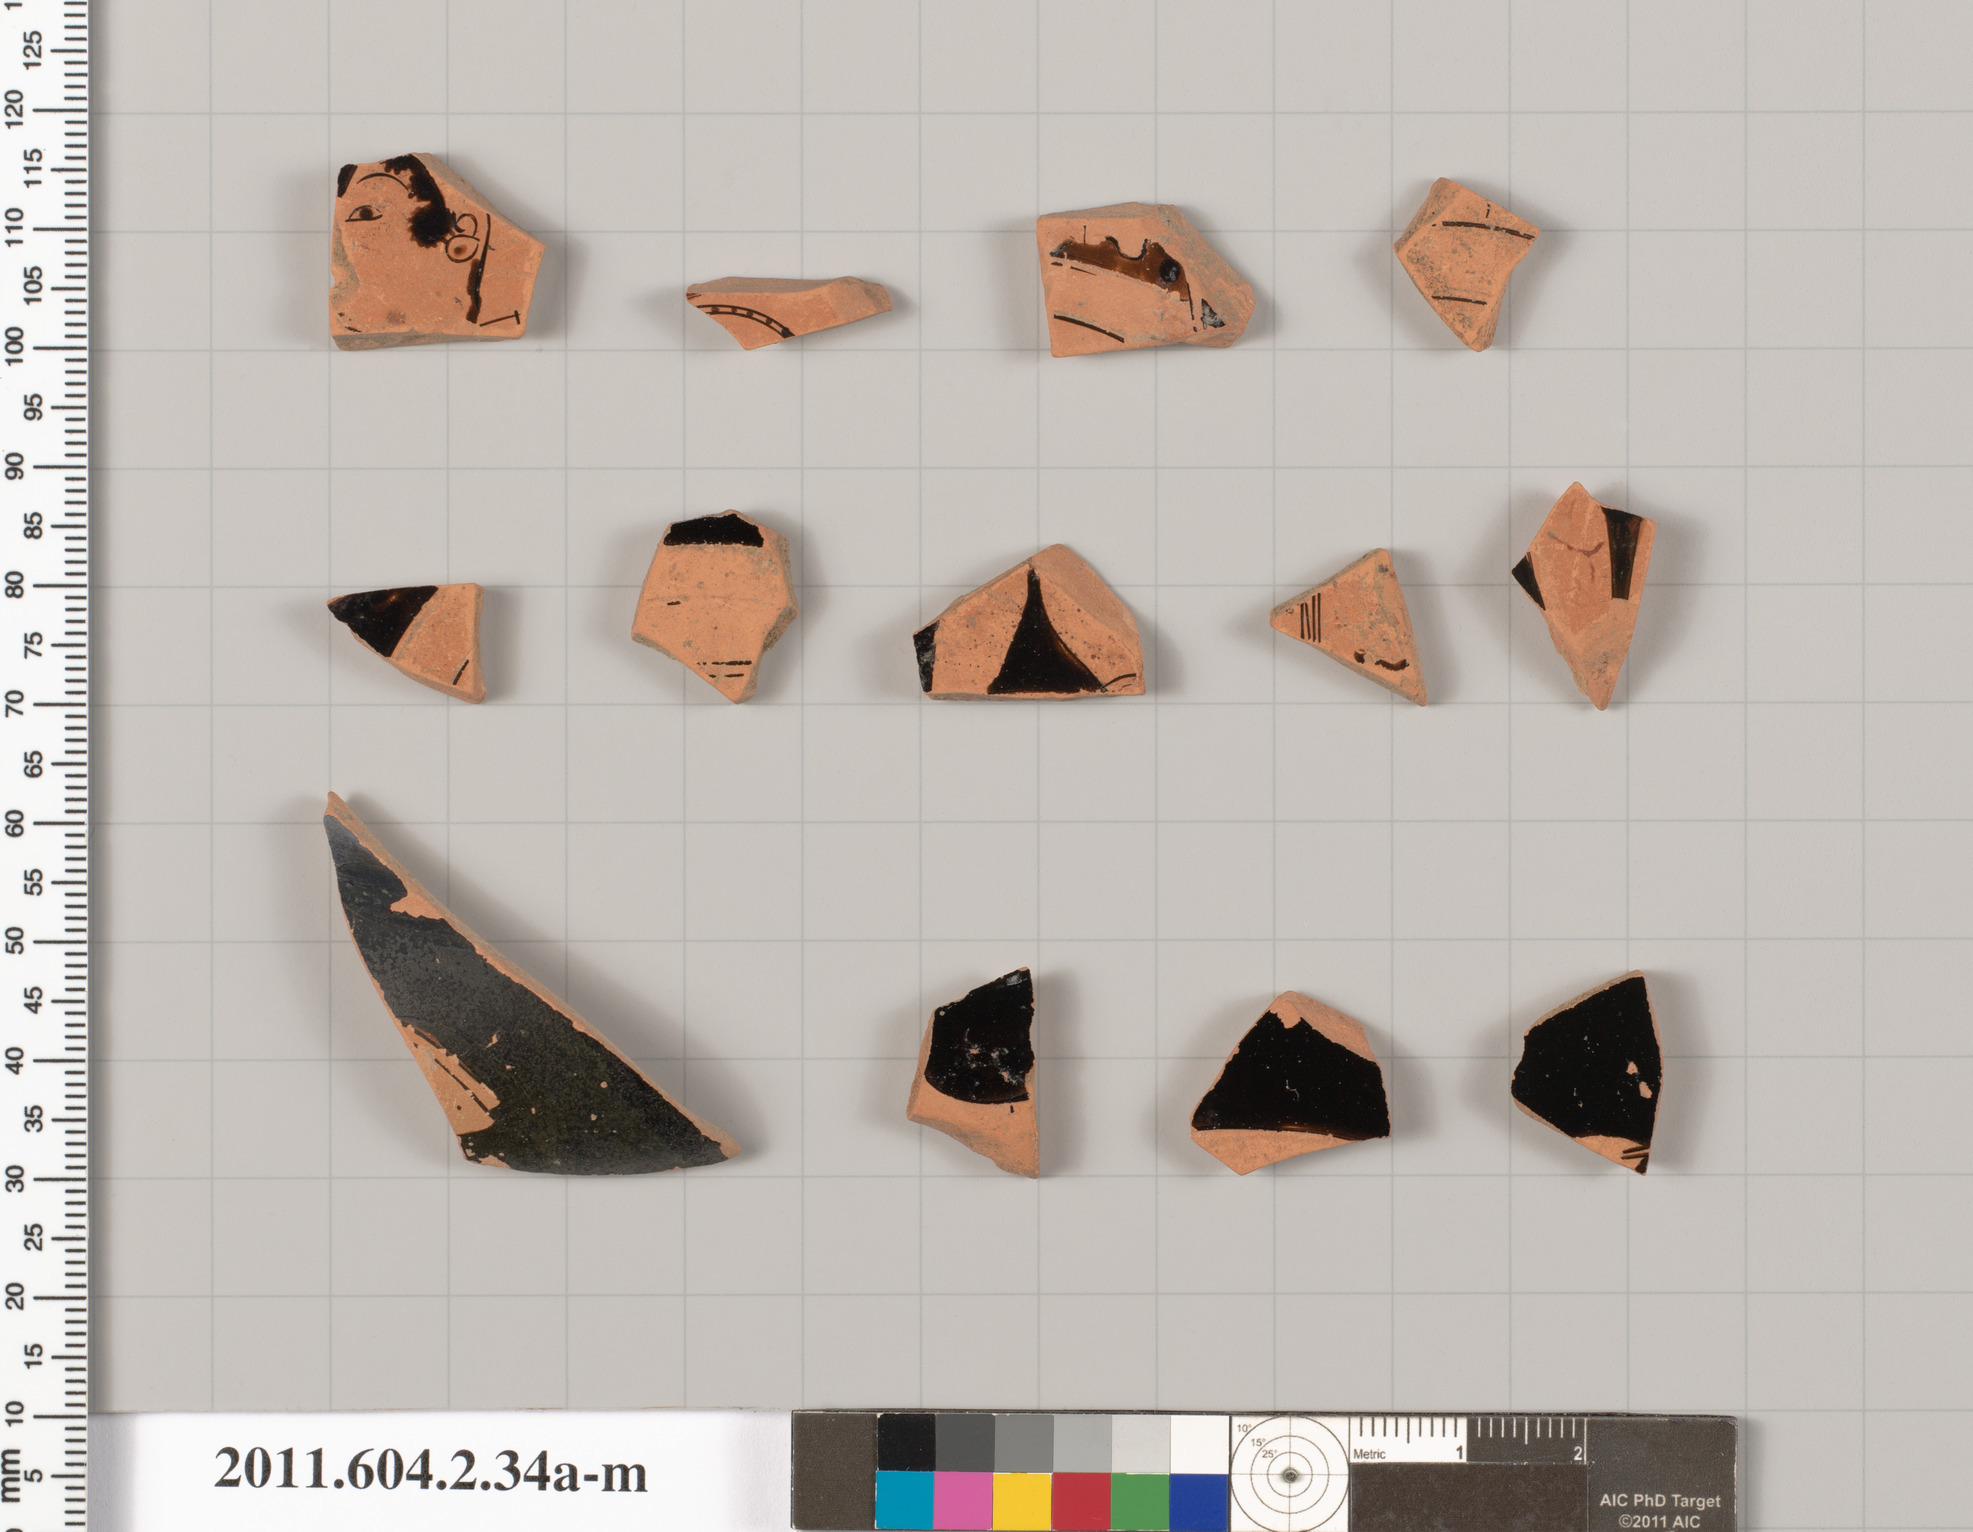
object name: psykter fragment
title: Terracotta fragments of a psykter? (vase for cooling wine)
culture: greek, attic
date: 500-480 BCE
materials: terracotta